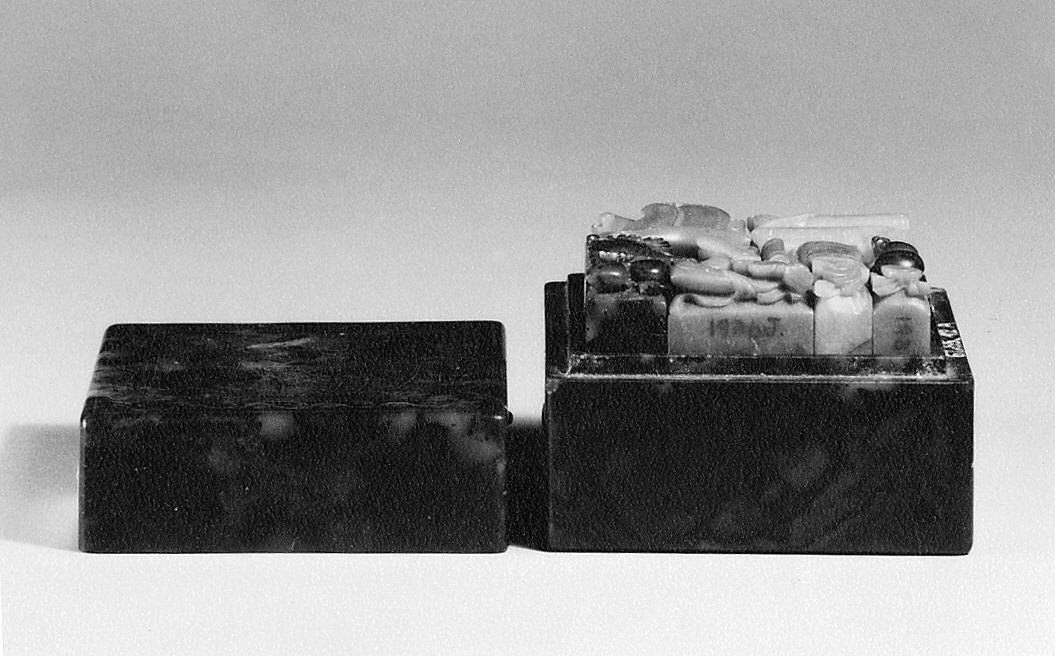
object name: seal box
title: Set of Ten Seals in a Box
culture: chinese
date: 1867-1933